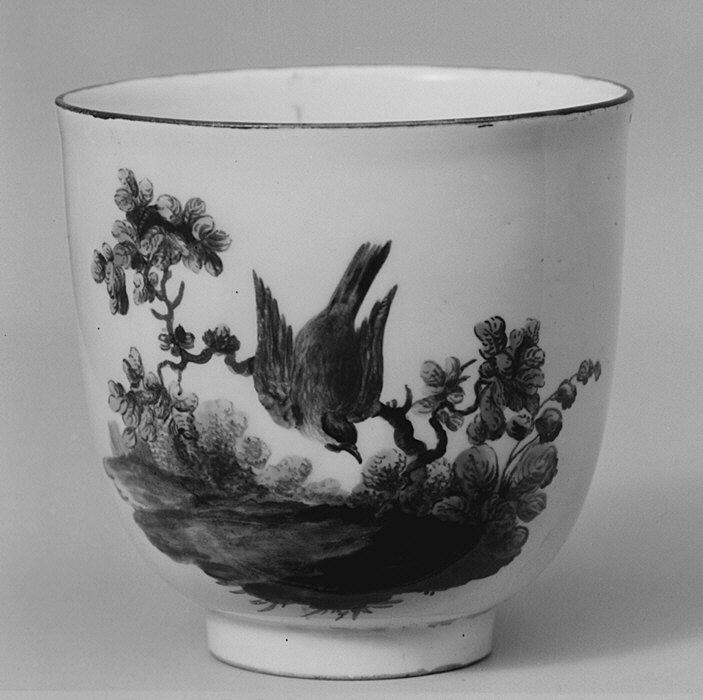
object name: cup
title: Cup (part of a service)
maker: frankenthal porcelain manufactory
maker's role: manufactory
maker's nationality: german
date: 1770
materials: hard paste porcelain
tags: birds,trees